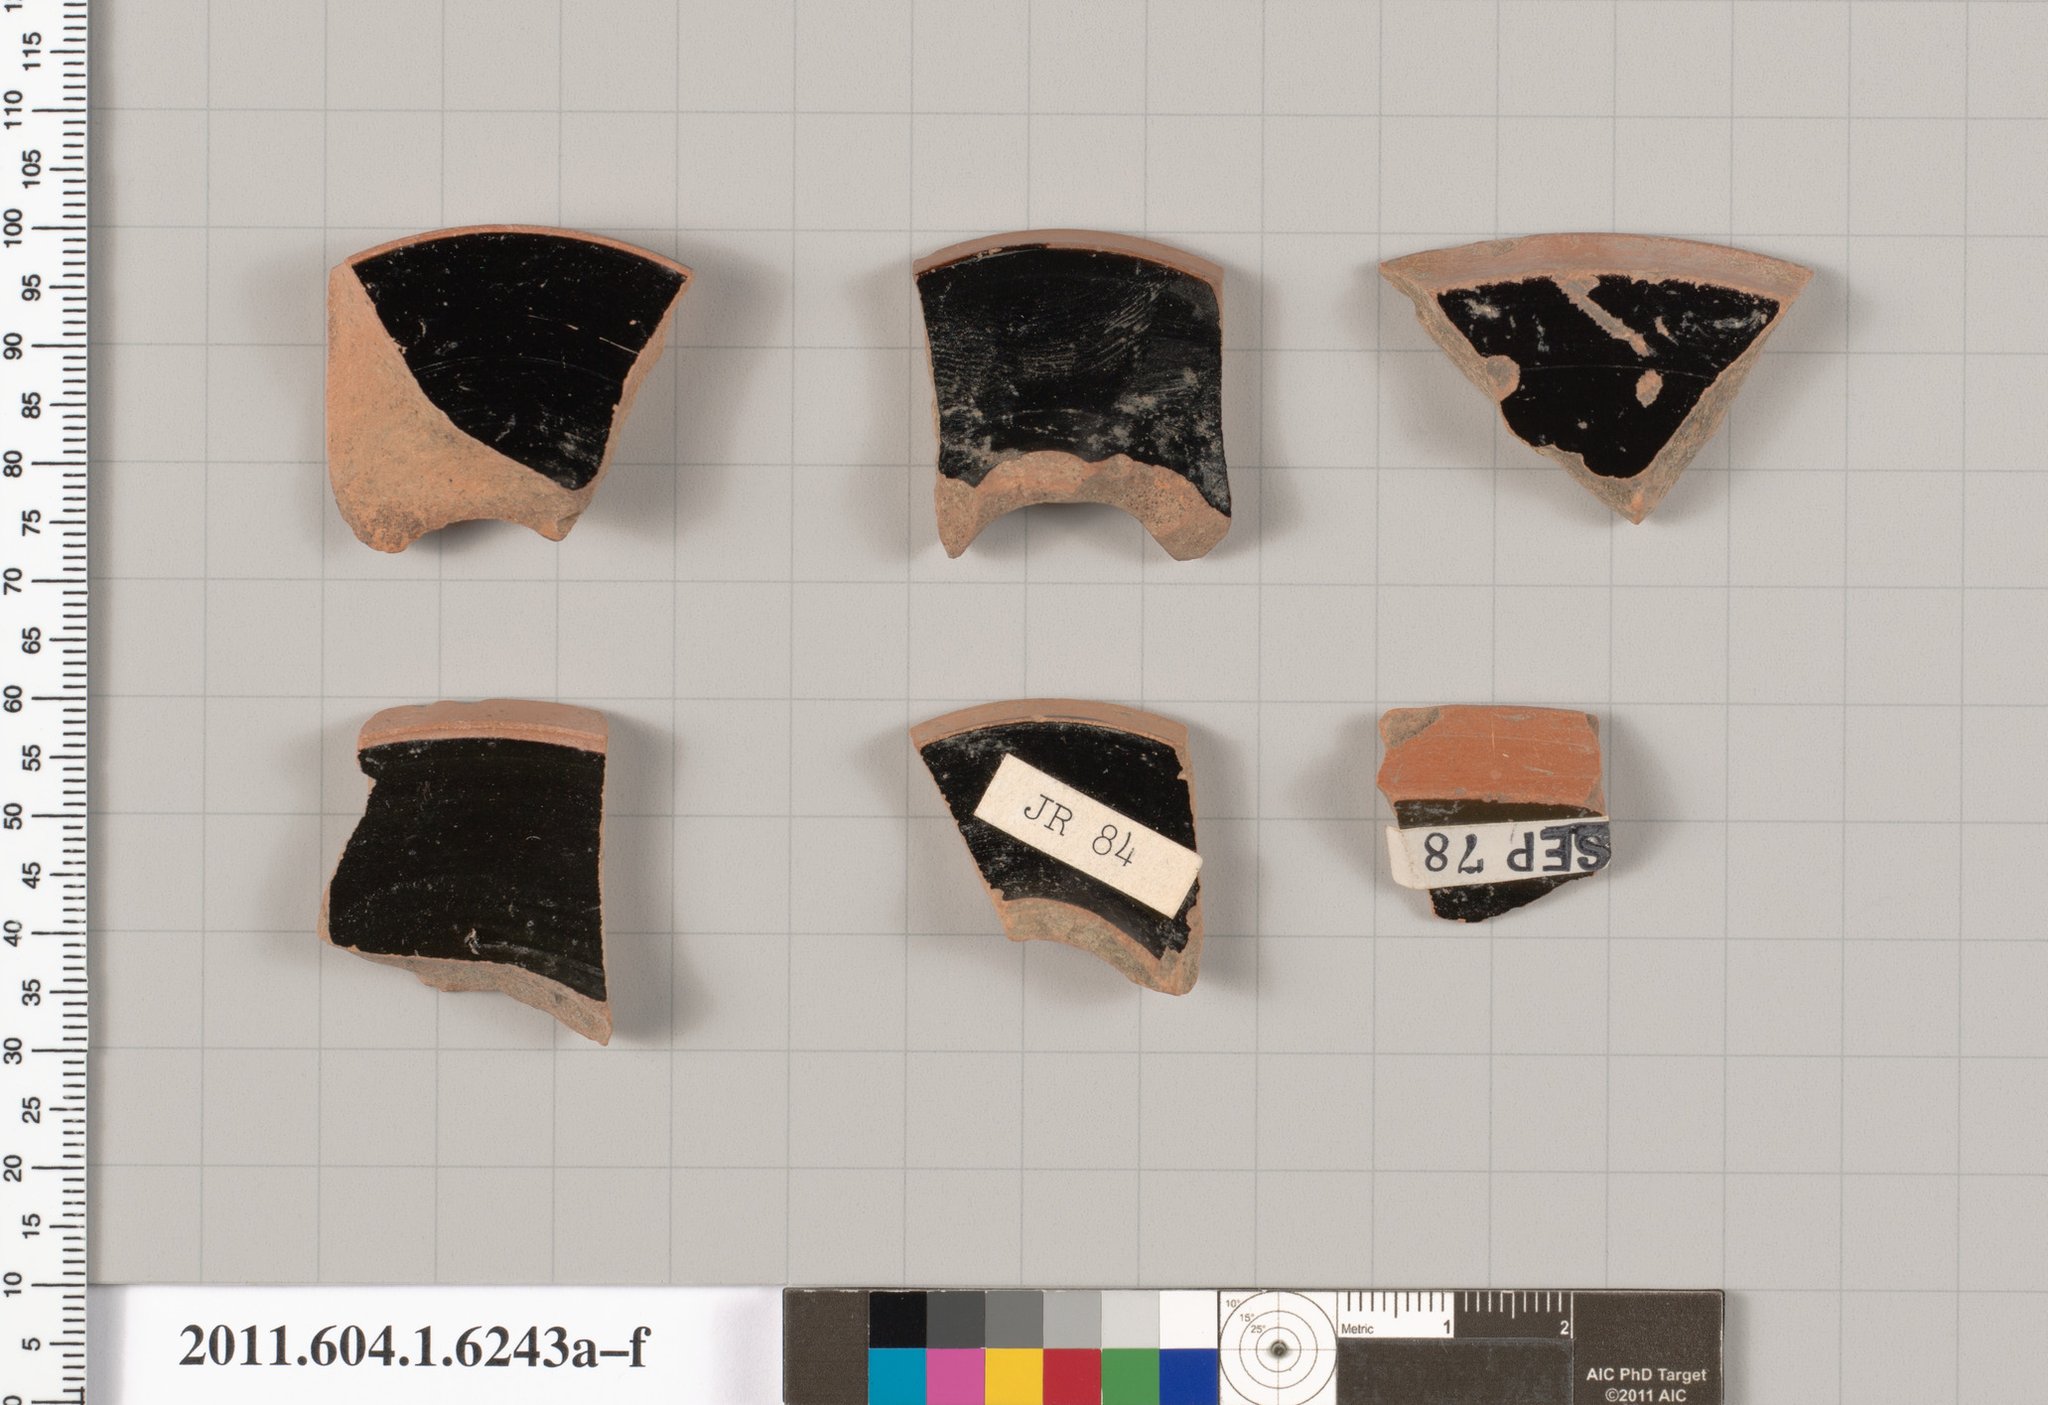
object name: kylix fragment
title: Terracotta fragments of kylikes (drinking cups)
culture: greek, attic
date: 534-468 BCE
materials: terracotta